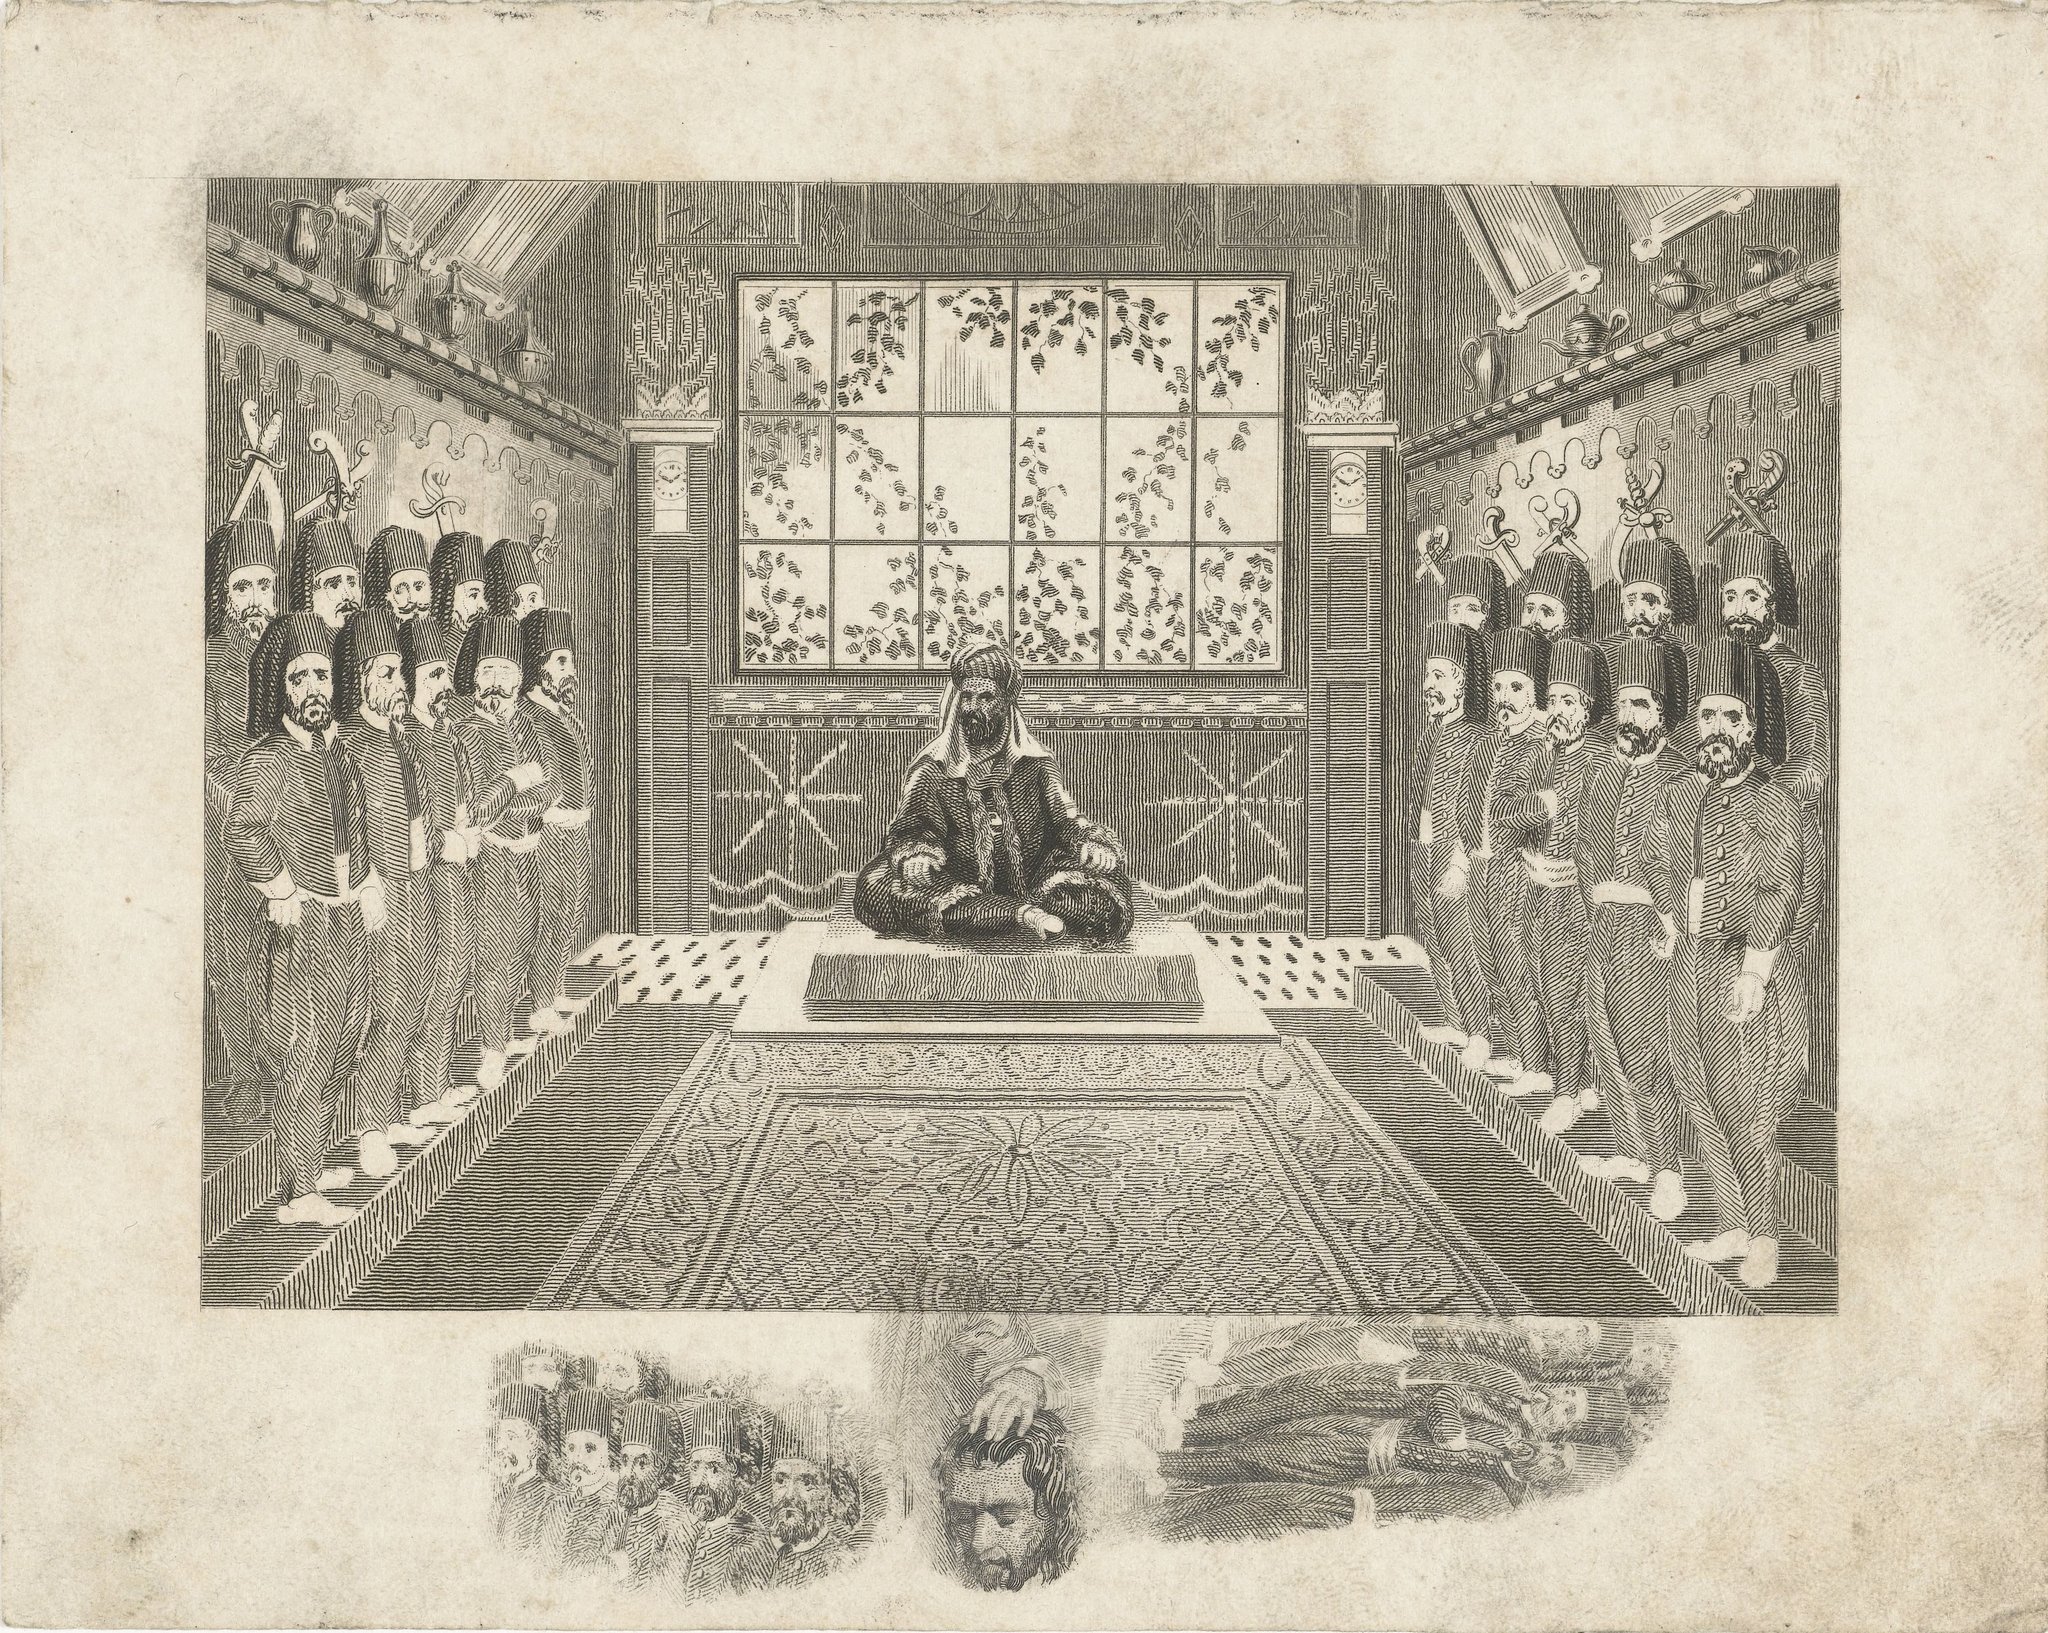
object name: book illustration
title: Man met tulband zittend in kleermakerszit en 19 soldaten die allen een fez dragen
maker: henricus wilhelmus couwenberg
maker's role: draughtsman, print maker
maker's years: 1814-1845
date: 1830-1845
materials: paper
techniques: engraving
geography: amsterdam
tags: head-gear: turban, asiatic races and peoples: persians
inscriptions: collector's mark: Lugt 2228